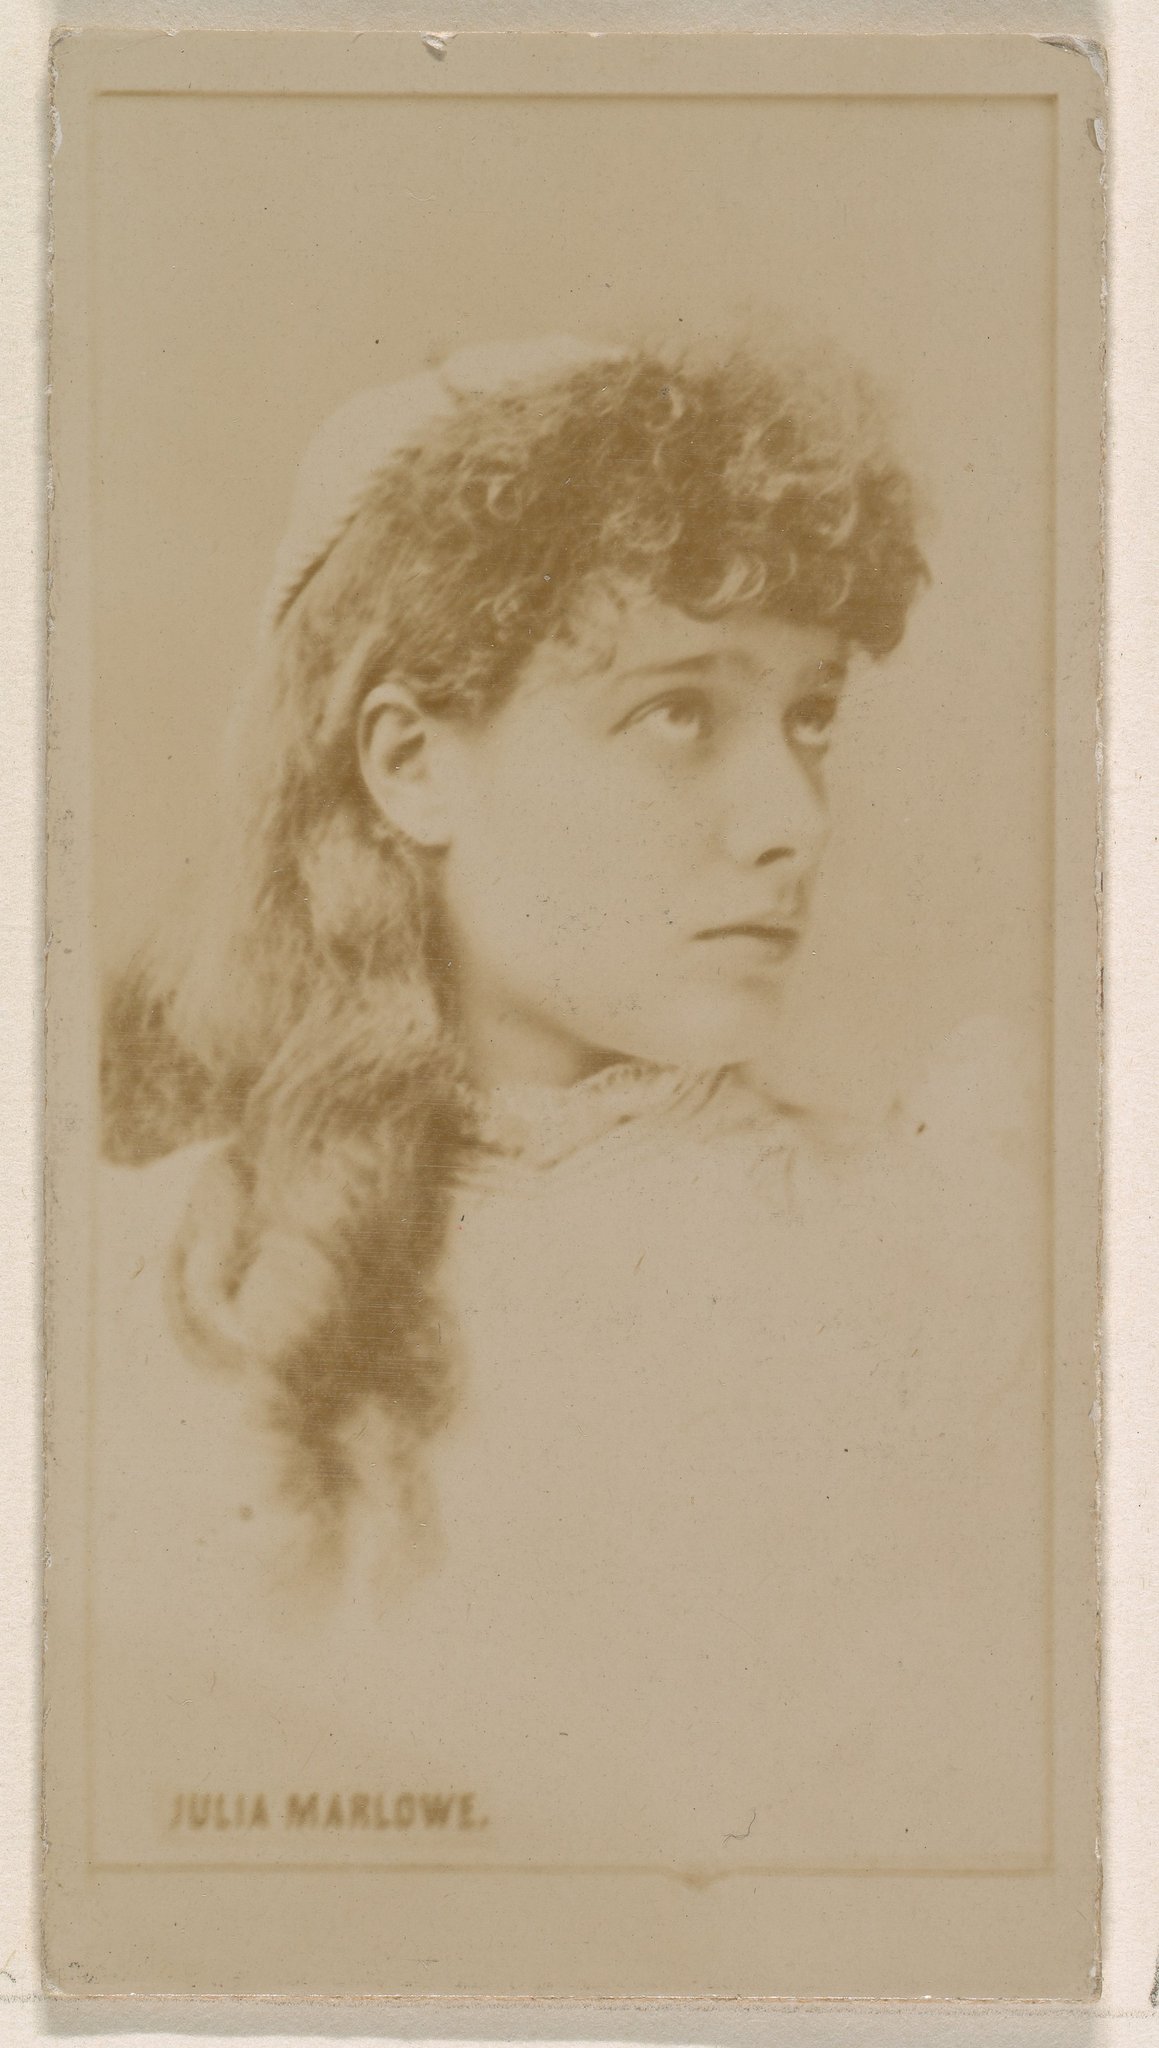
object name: photograph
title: Julia Marlowe, from the Actresses series (N245) issued by Kinney Brothers to promote Sweet Caporal Cigarettes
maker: kinney brothers tobacco company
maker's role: publisher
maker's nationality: american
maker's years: 1869-2011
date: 1890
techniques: albumen silver print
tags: portraits,women,actresses